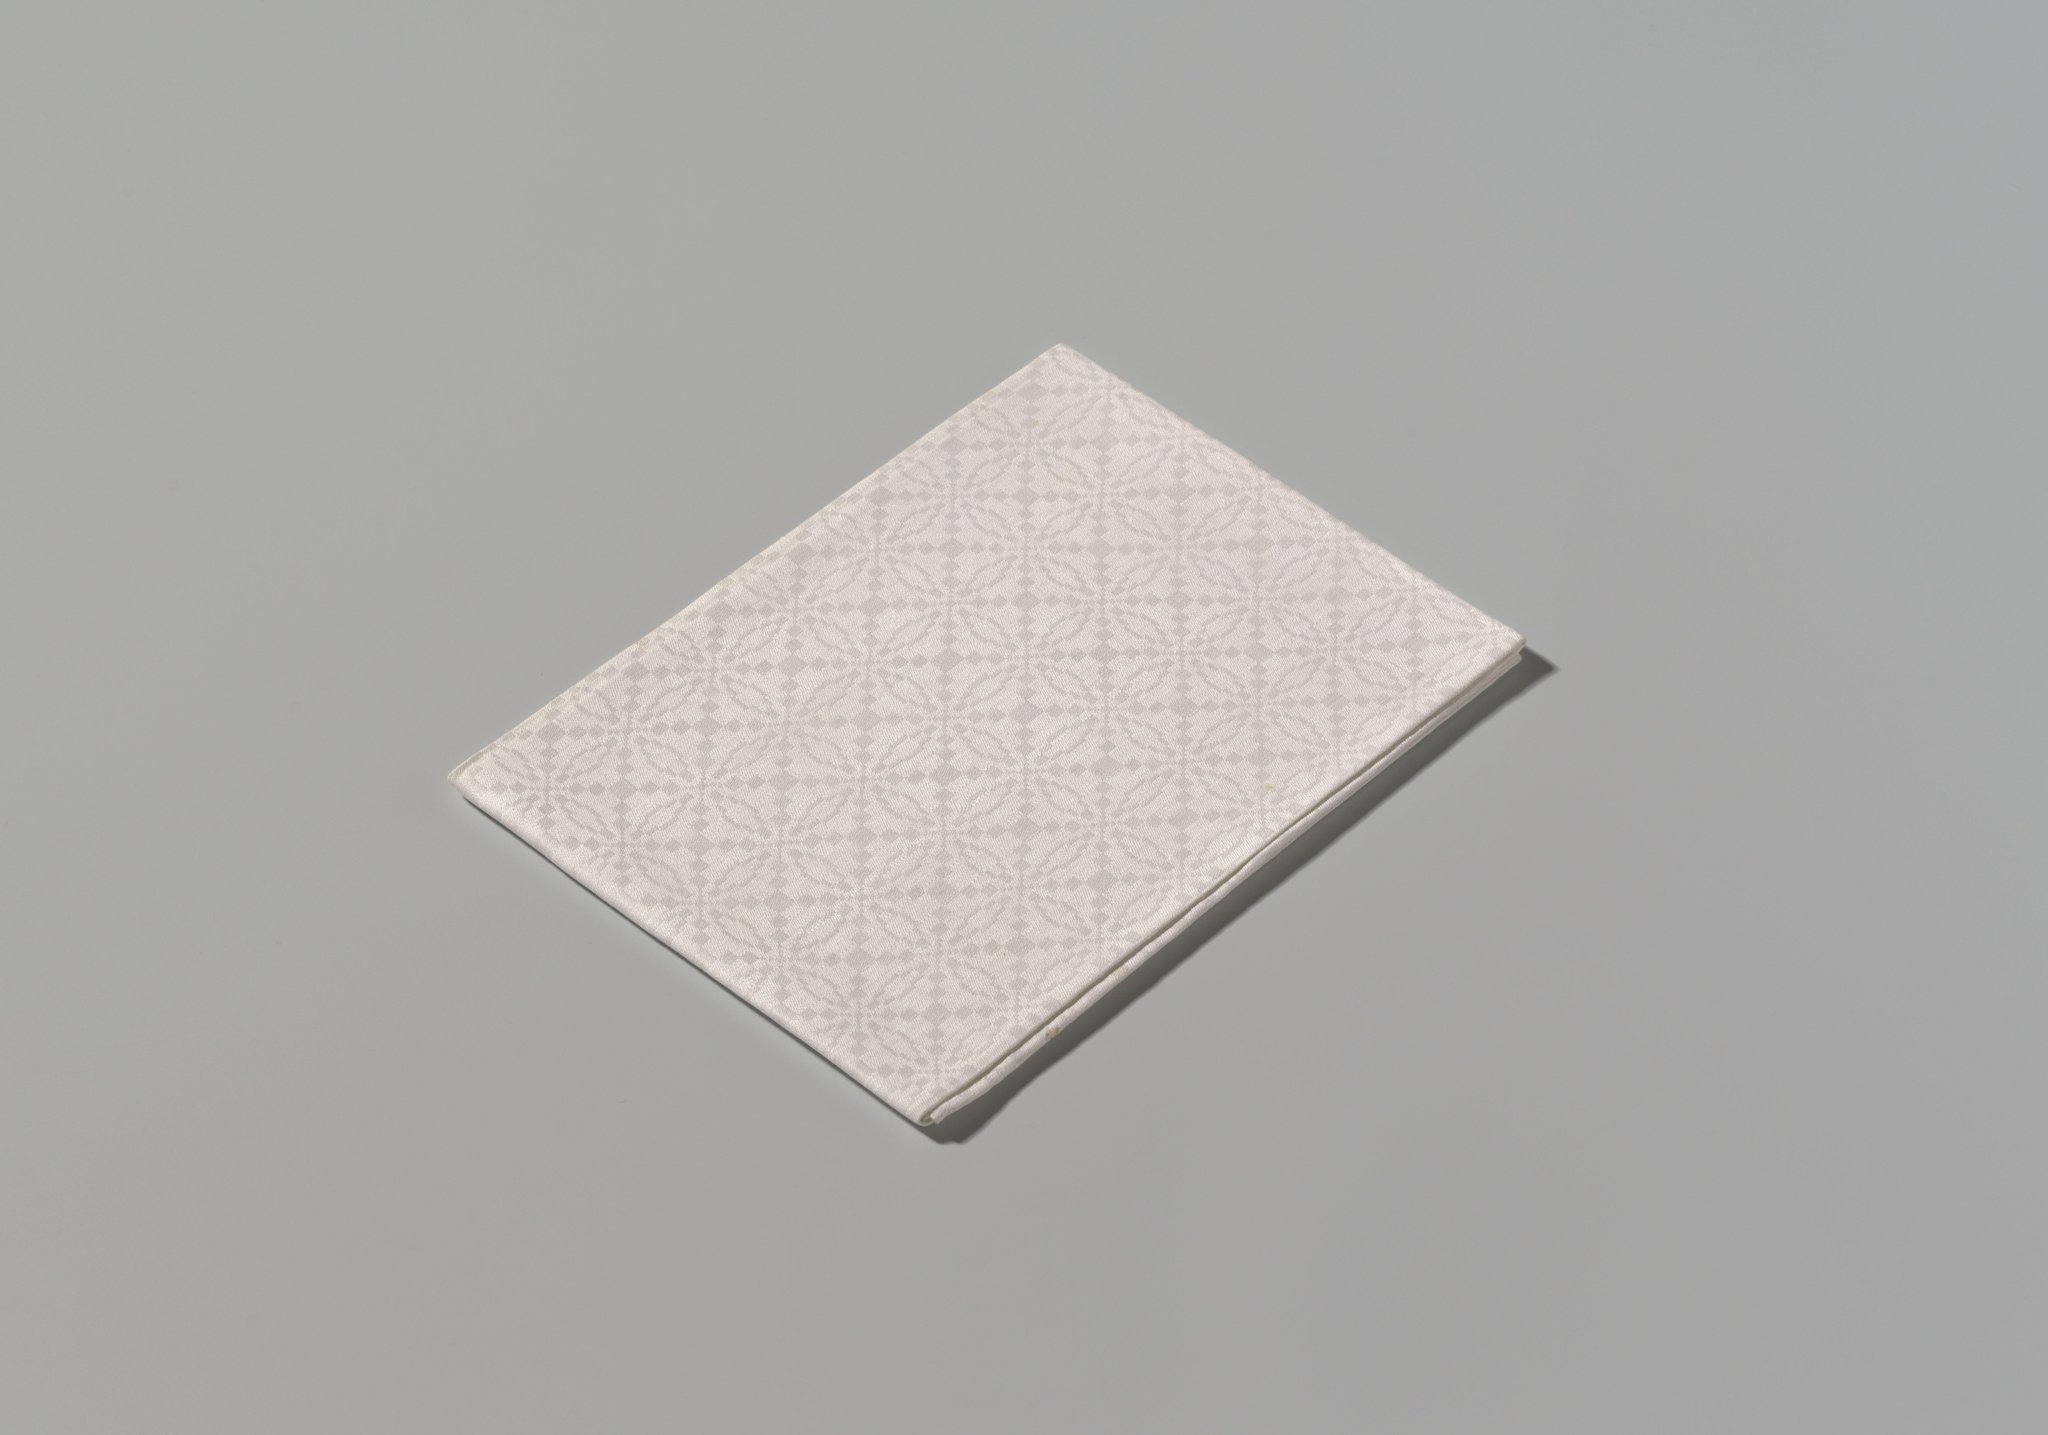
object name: napkin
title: Wit linnen pellen servet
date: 1600-1650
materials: linen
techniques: peeled fabric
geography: northern netherlands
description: Wit linnen pellen servet, gemerkt WO 70.